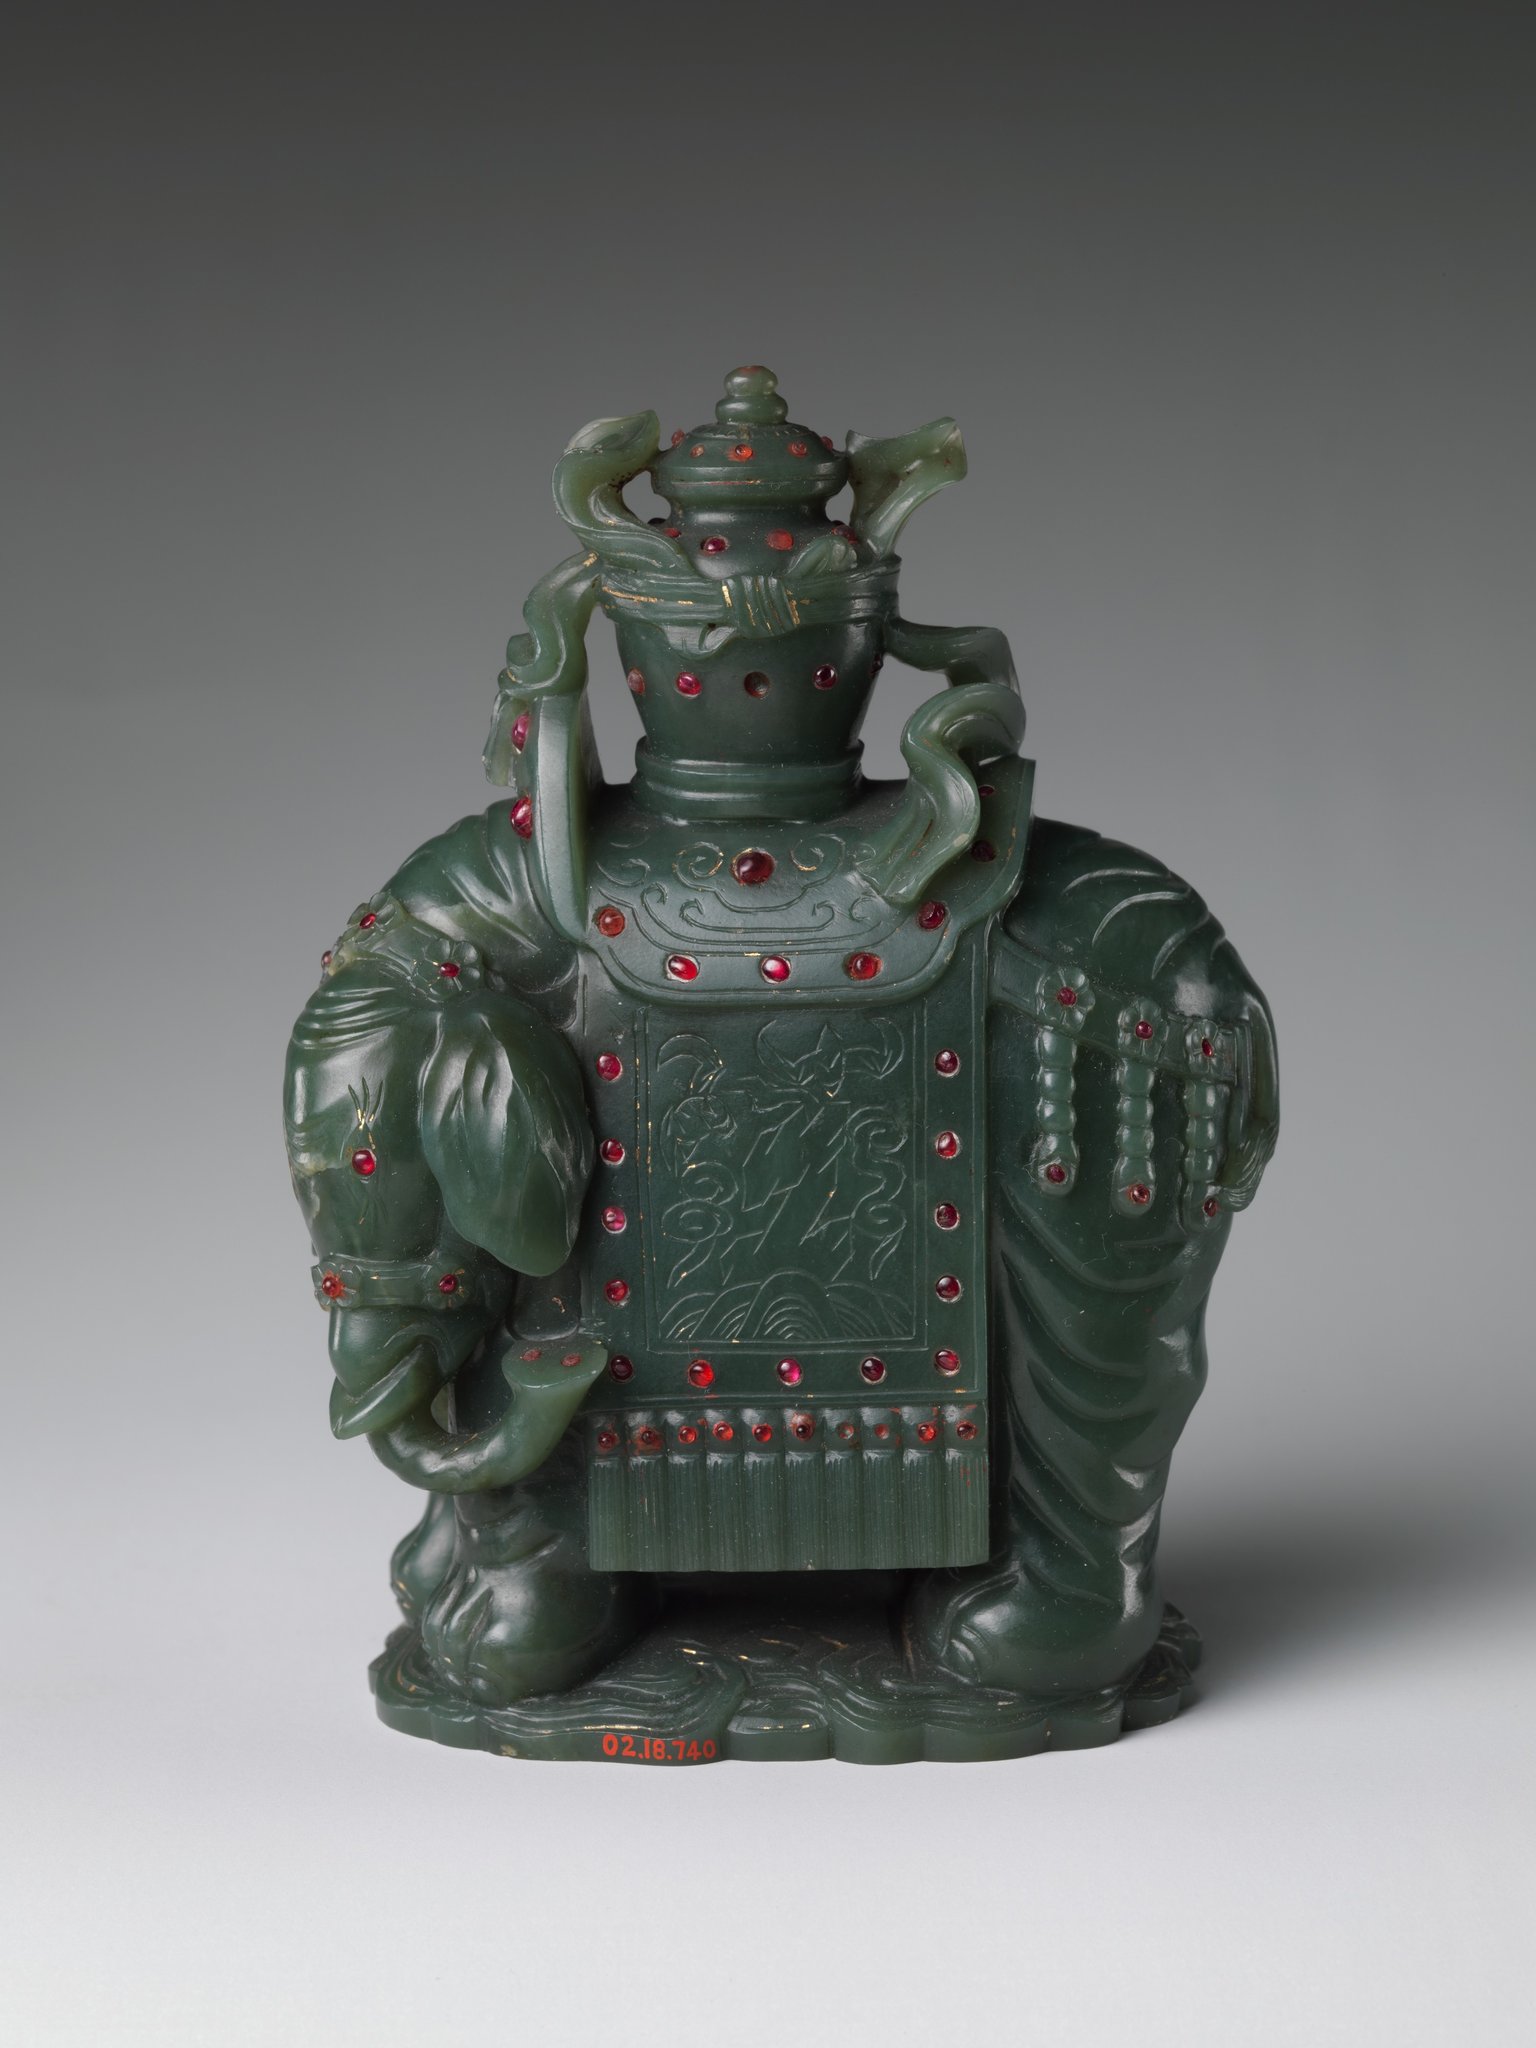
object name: figure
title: Elephant carrying a vase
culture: chinese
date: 1701-1900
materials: jade, stone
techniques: inlay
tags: elephants